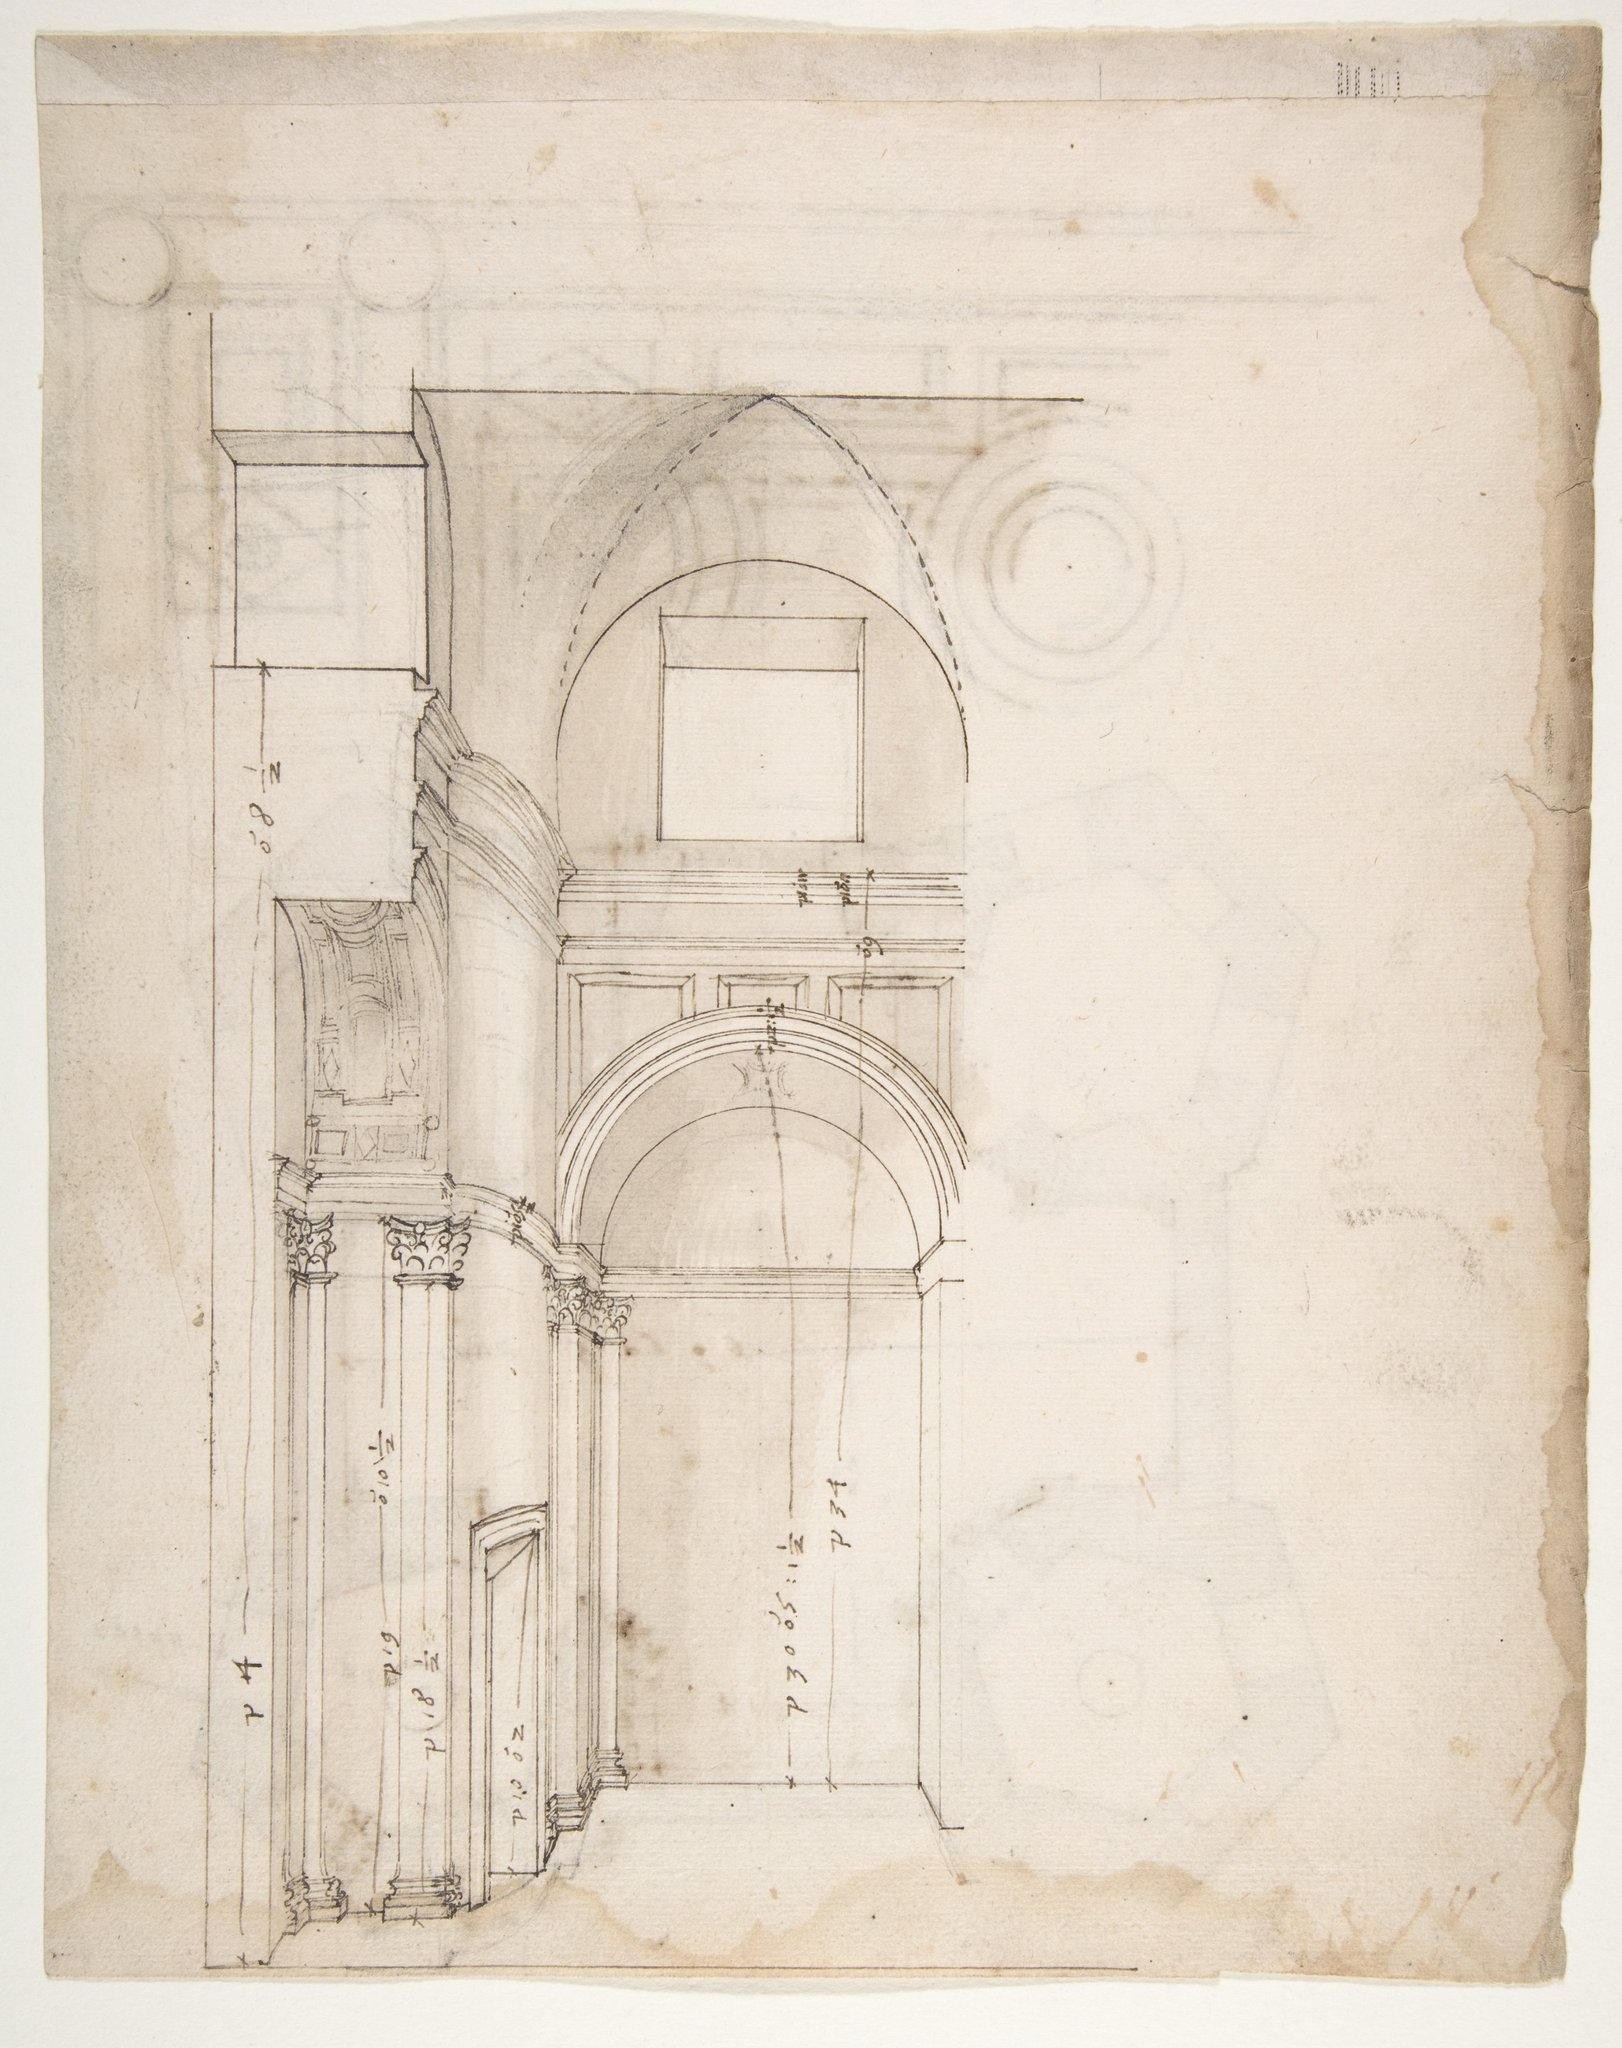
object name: collection ornament architecture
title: S. Giovanni Laterno, Oratorio della Santa Croce, section, perspective (recto) blank (verso)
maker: anonymous, french, 16th century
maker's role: draftsman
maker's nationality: french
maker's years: 1500-1600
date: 1540-1560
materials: chalk, ink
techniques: incising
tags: architecture